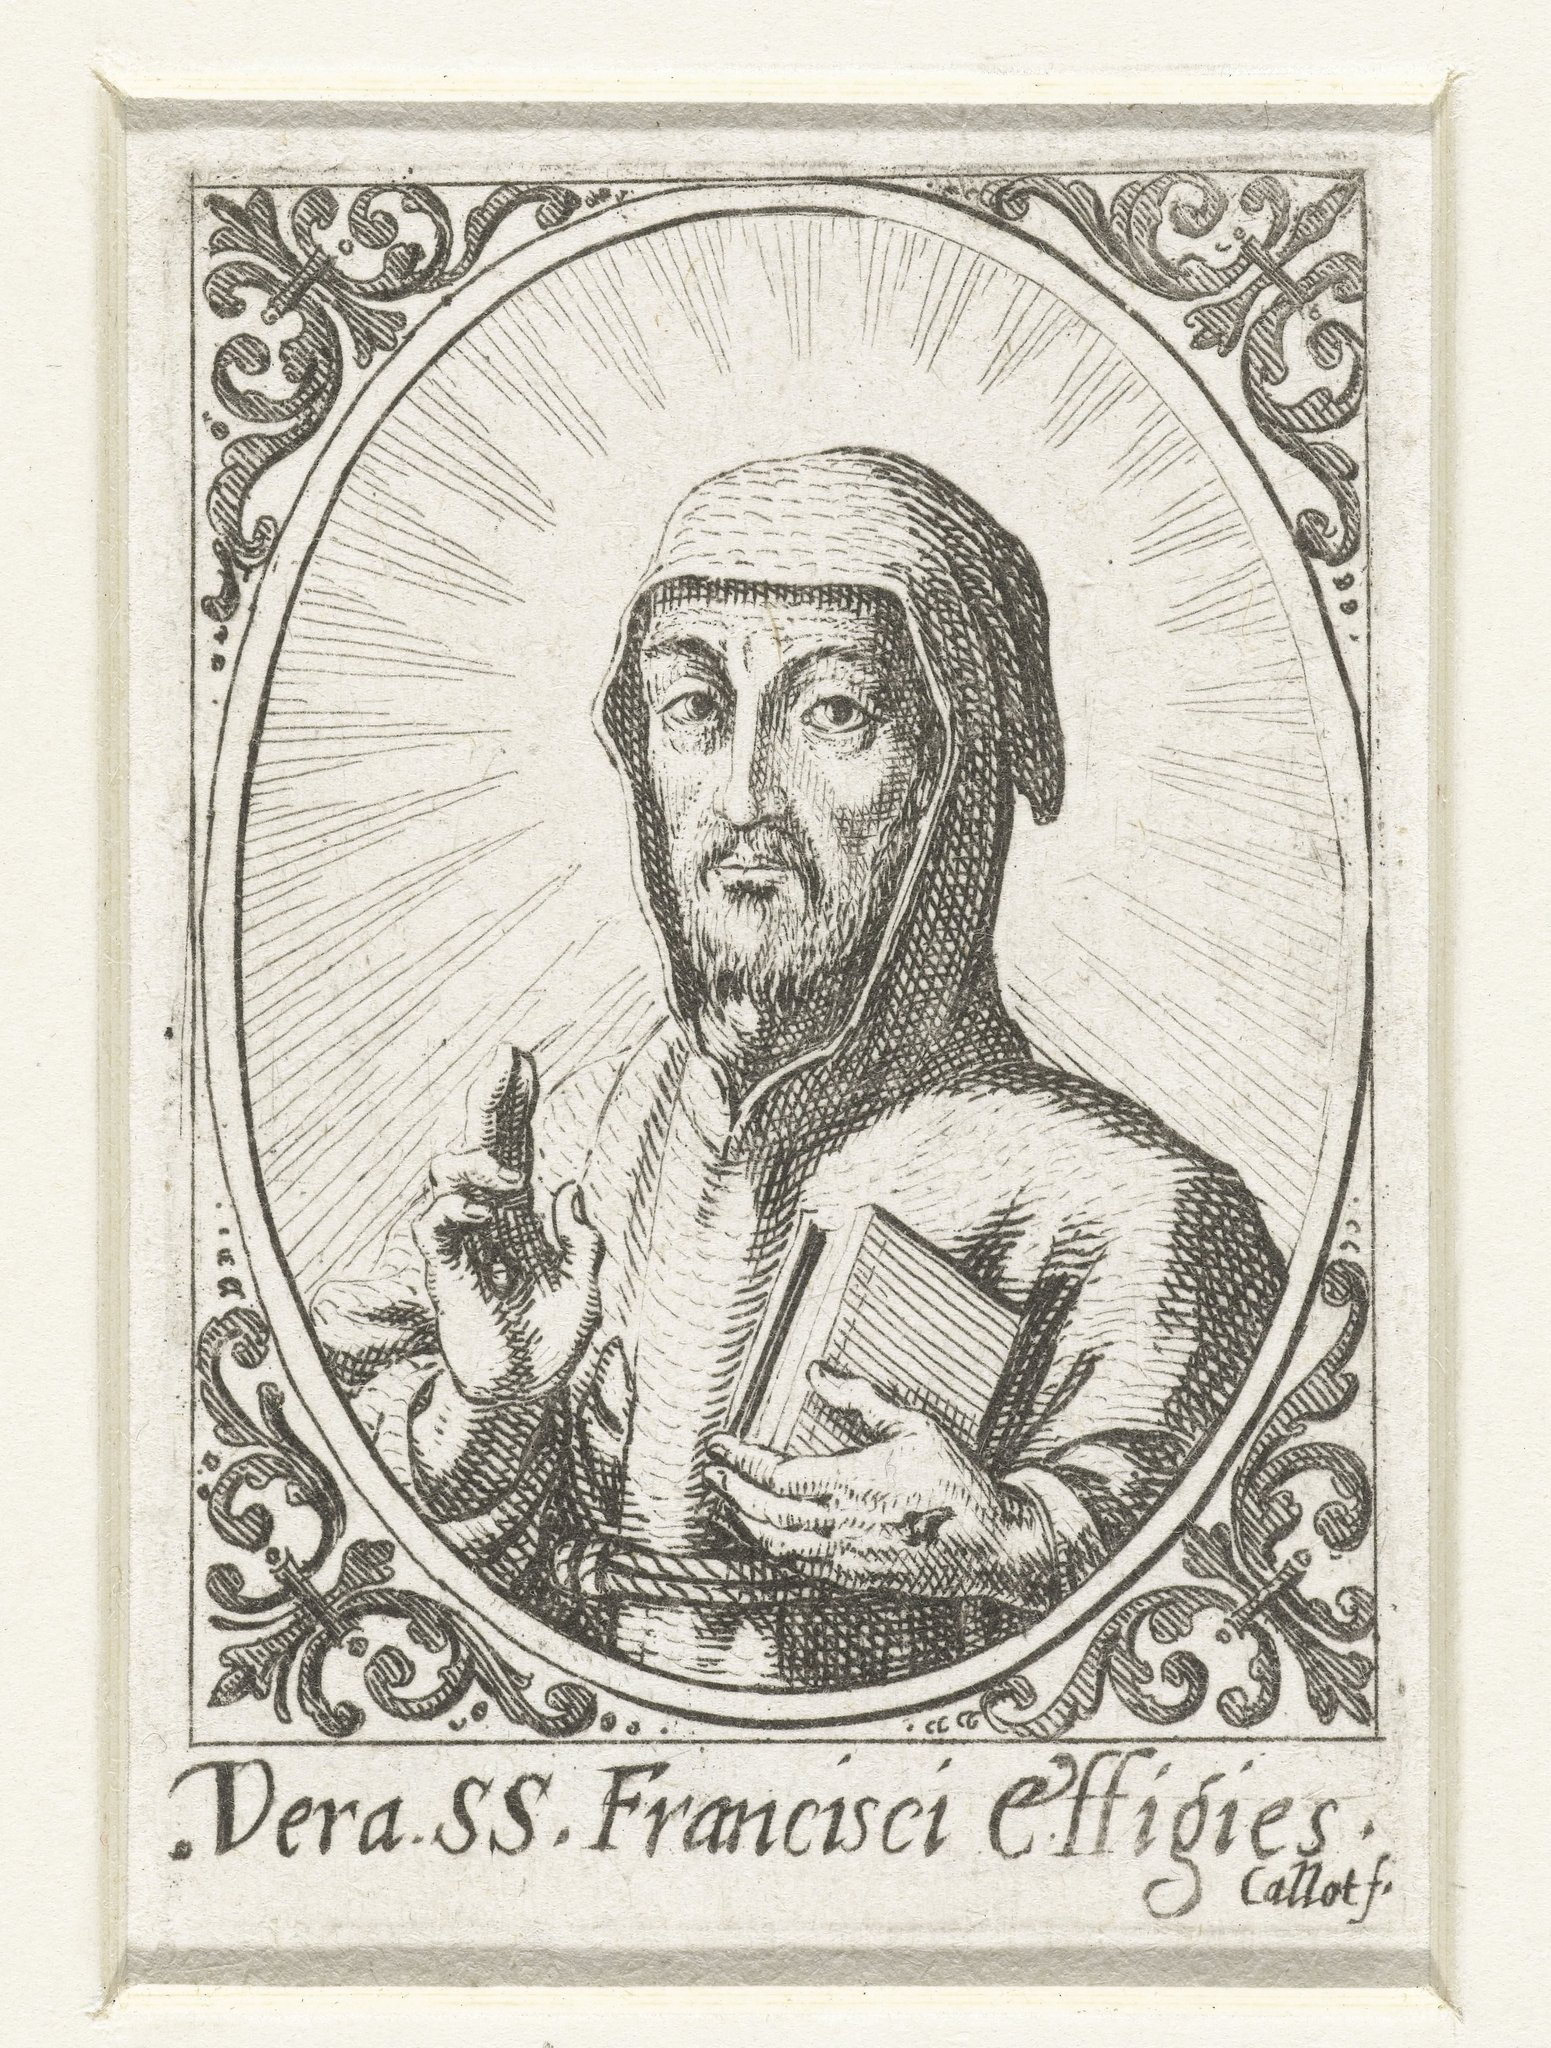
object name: print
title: Vera SS. Francisci Effigies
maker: jacques callot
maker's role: draughtsman, print maker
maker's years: 1592-1635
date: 1620-1621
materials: paper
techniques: engraving, etching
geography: florence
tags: founder of the order of friars minor (franciscans), francis(cus) of assisi; possible attributes: book, crucifix, lily, skull, stigmata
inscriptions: collector's mark: Lugt 240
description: Busteportret van de Heilige Franciscus, in de linkerhand een boek, de rechterhand opgestoken in een zegenend gebaar. Onder de voorstelling een onderschrift in Latijn.